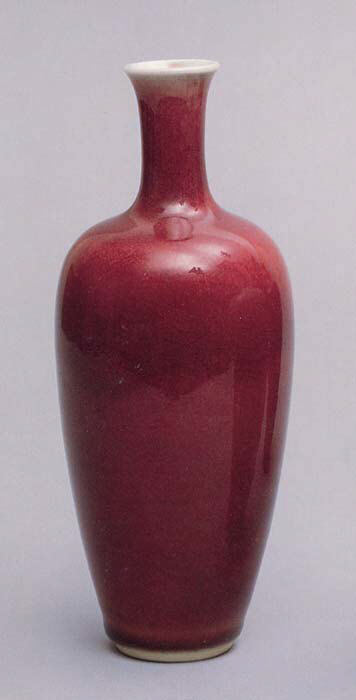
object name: vase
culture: chinese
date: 1701-1733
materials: glaze, porcelain